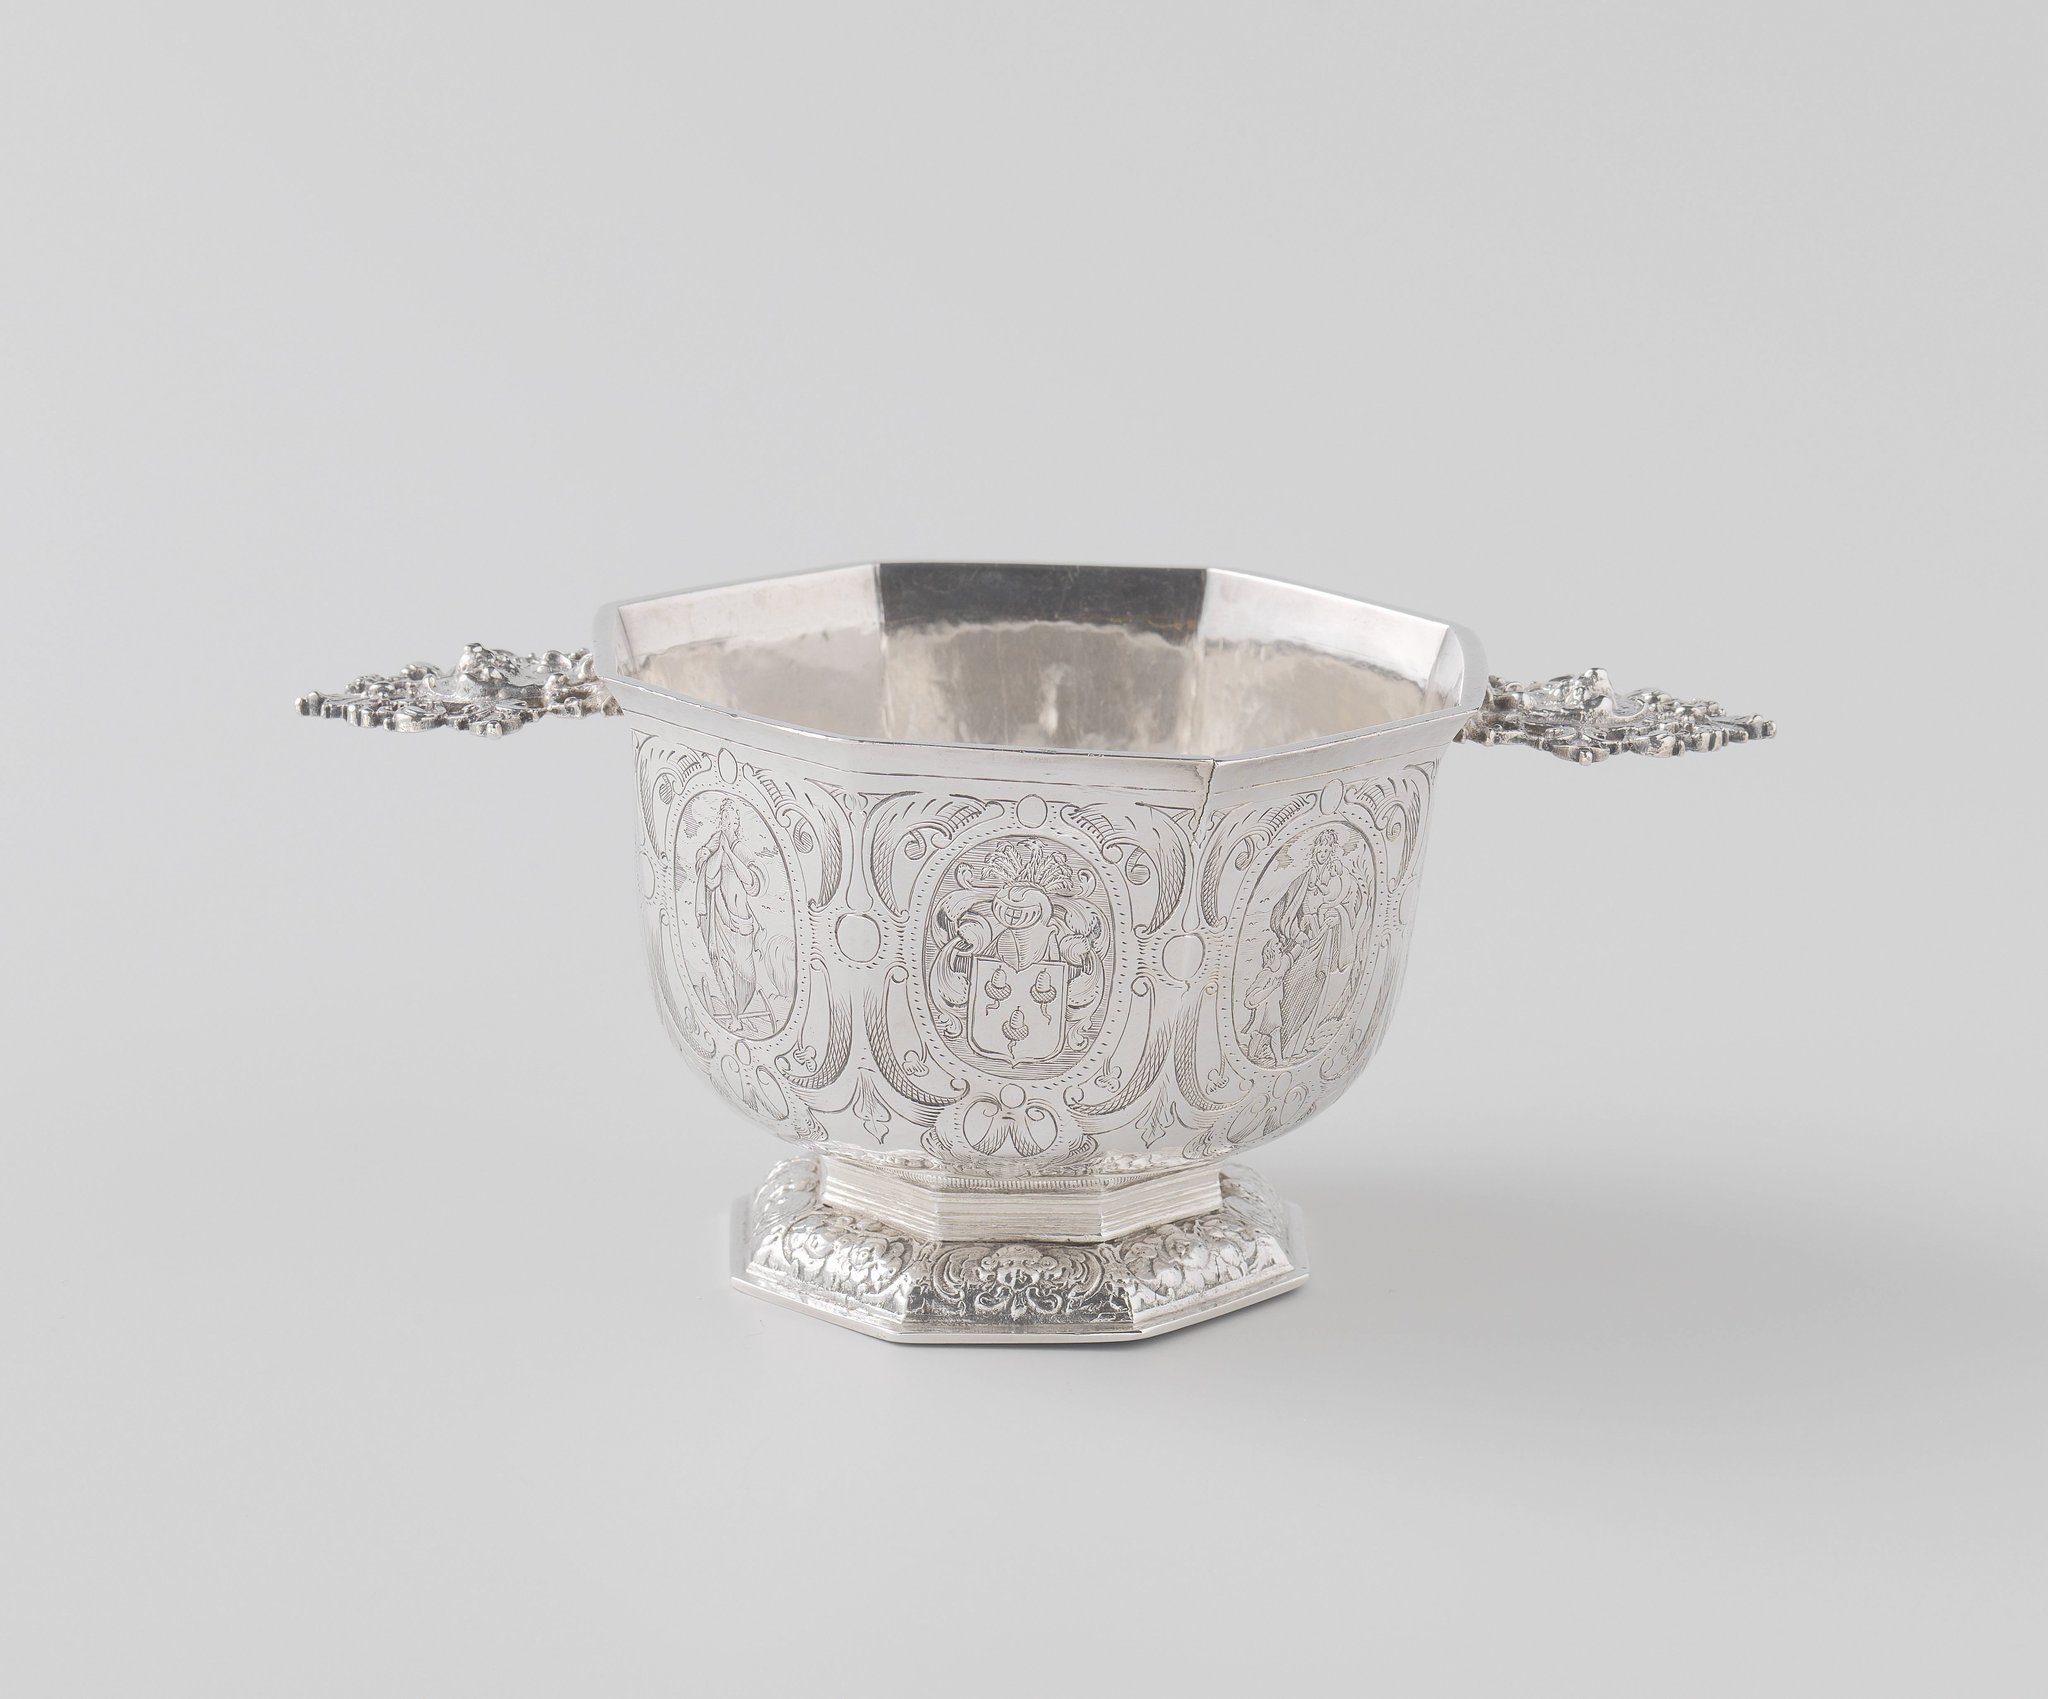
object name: brandy bowl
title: Brandewijnkom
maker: scholte janssen (ii)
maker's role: silversmith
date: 1667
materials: silver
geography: sneek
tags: charity, 'caritas'; 'carità' (ripa) ~ one of the three theological virtues, hope, 'spes'; 'speranza divina e certa' (ripa) ~ one of the three theological virtues, armorial bearing, heraldry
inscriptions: maker's mark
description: Brandewijnkom van zilver met een hoge, achtkantige, gegraveerde cuppa en twee horizontale, gegoten rolwerk-oren. Meesterteken: gekroonde eikel.